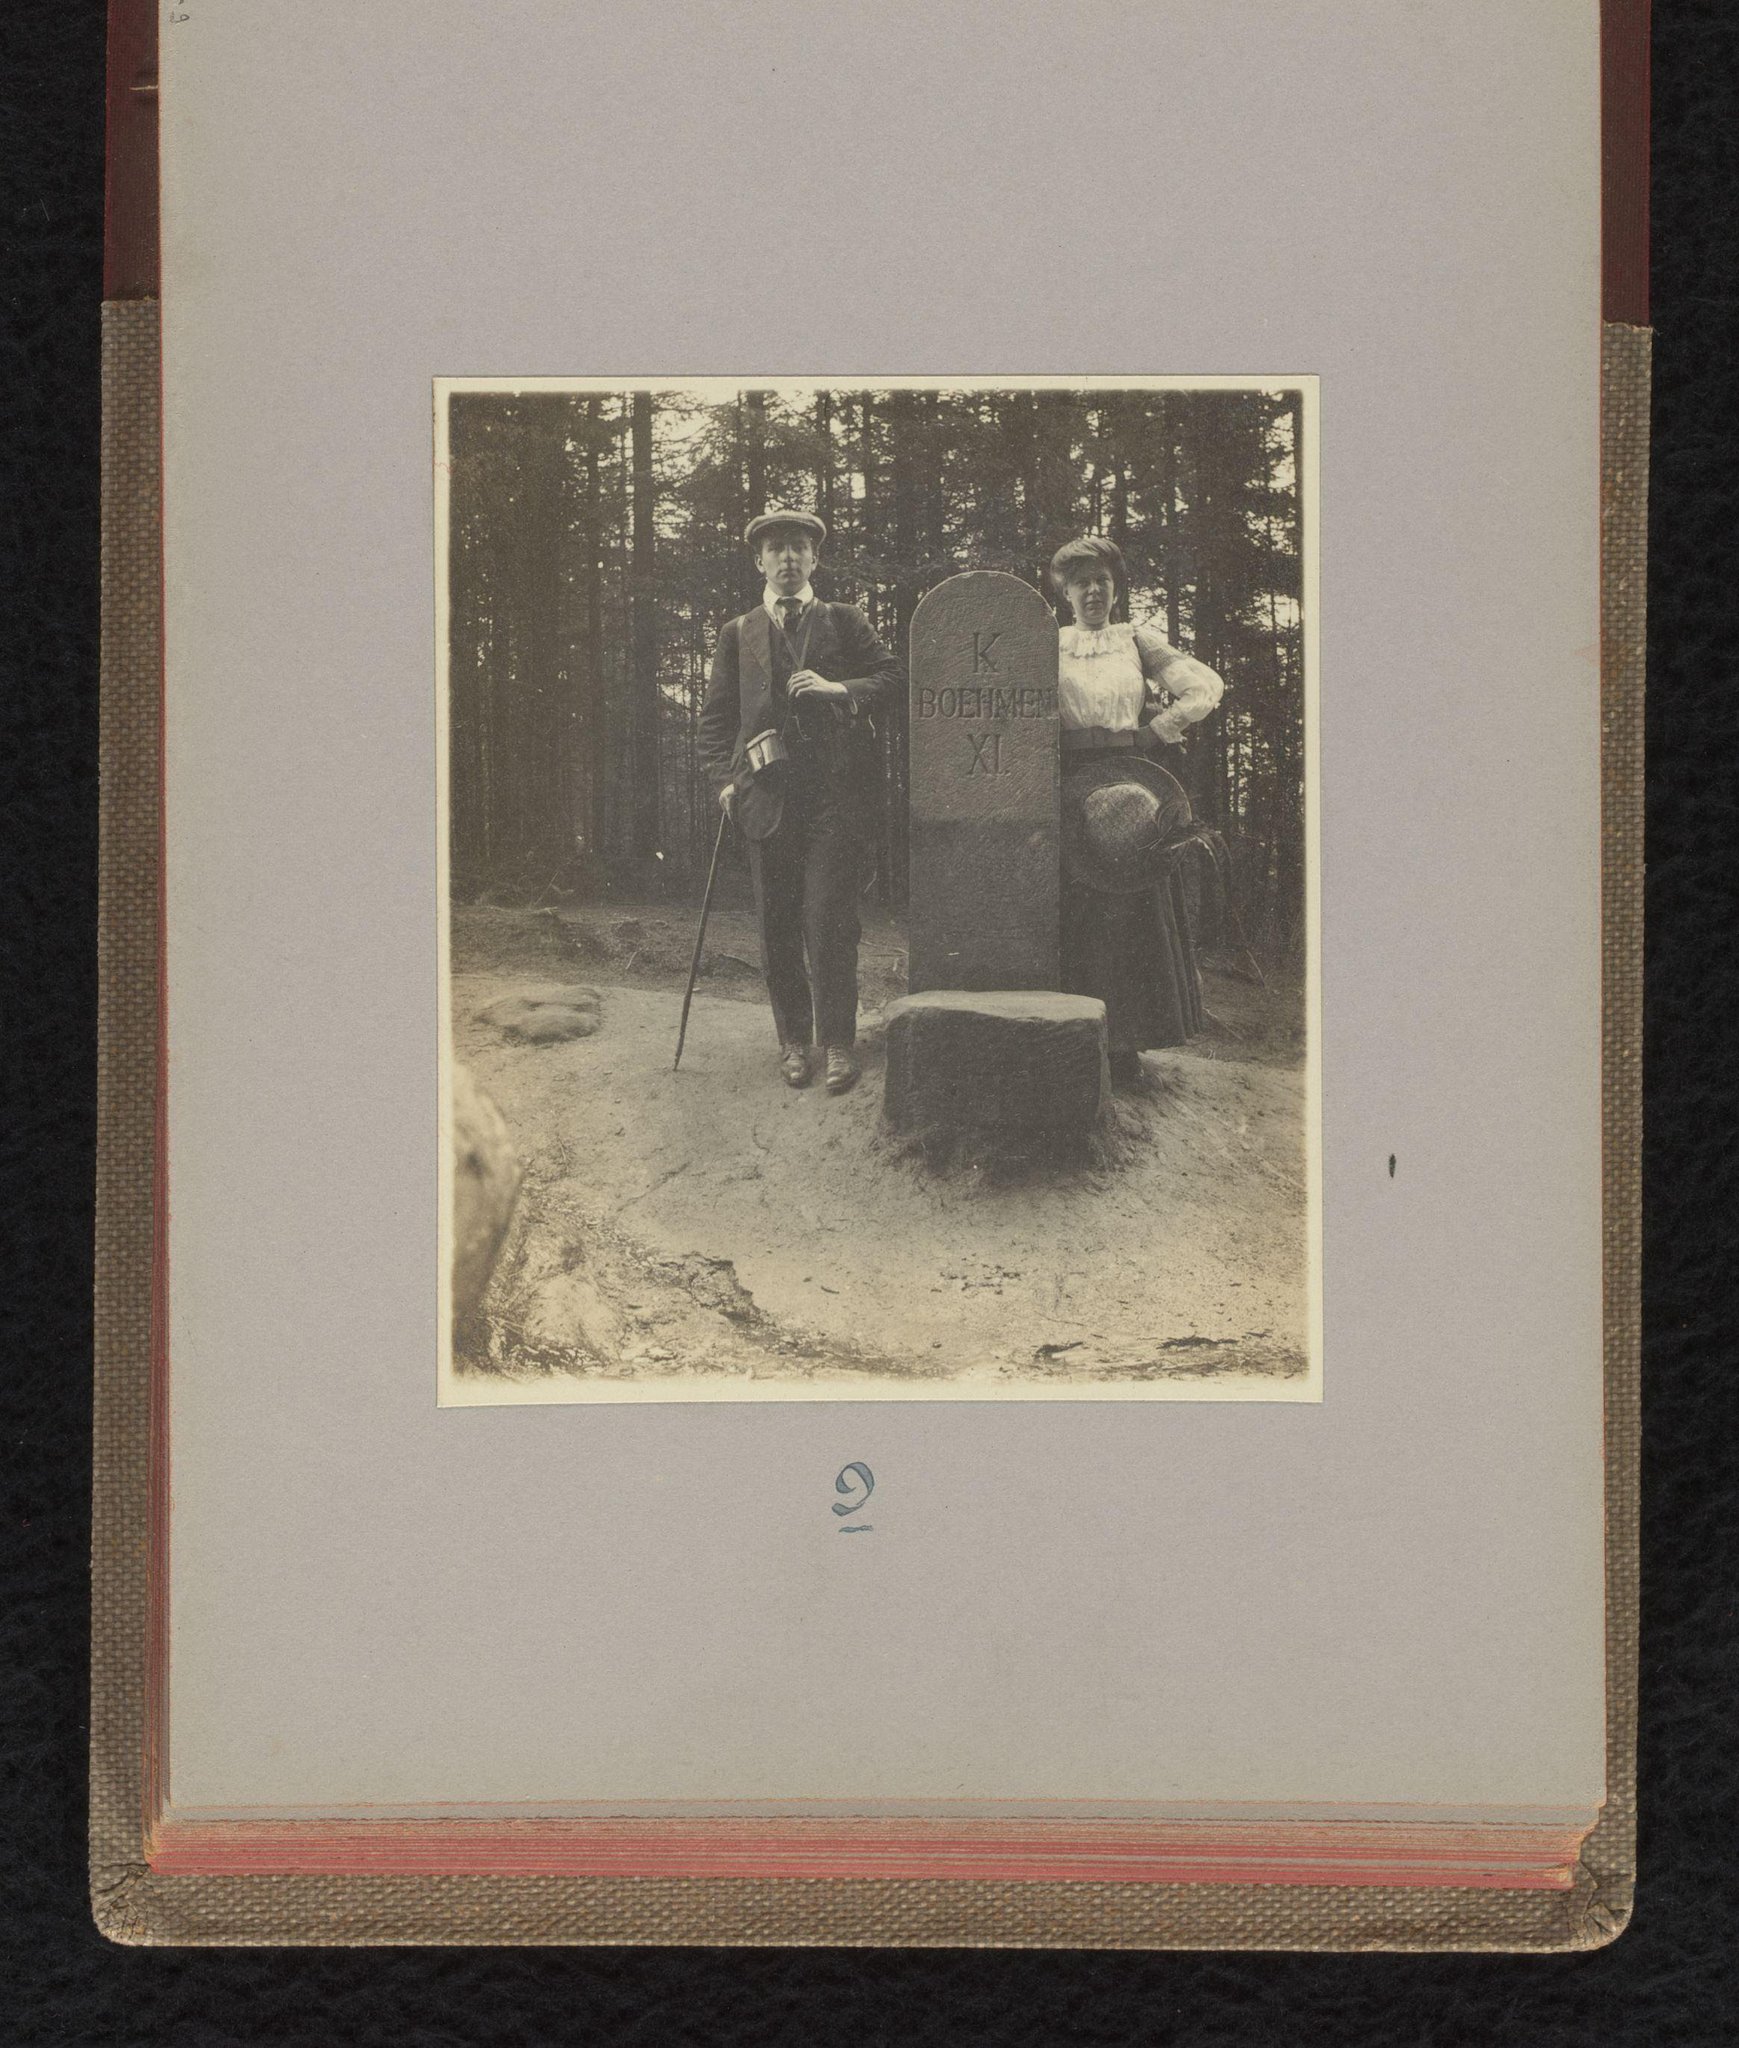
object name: album leaf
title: Grens van Saksen en Bohemen - "op de grens van Saksen en Bohemen heeft Boelie een kiekje willen nemen"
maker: hermann johannes kessler (boelie)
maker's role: voetballer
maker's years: 1896-1971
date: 1910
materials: paper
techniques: gelatin silver print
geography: saxony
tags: johan herman kessler (jan), boundary-post, boundary-stone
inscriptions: number: ‘9’